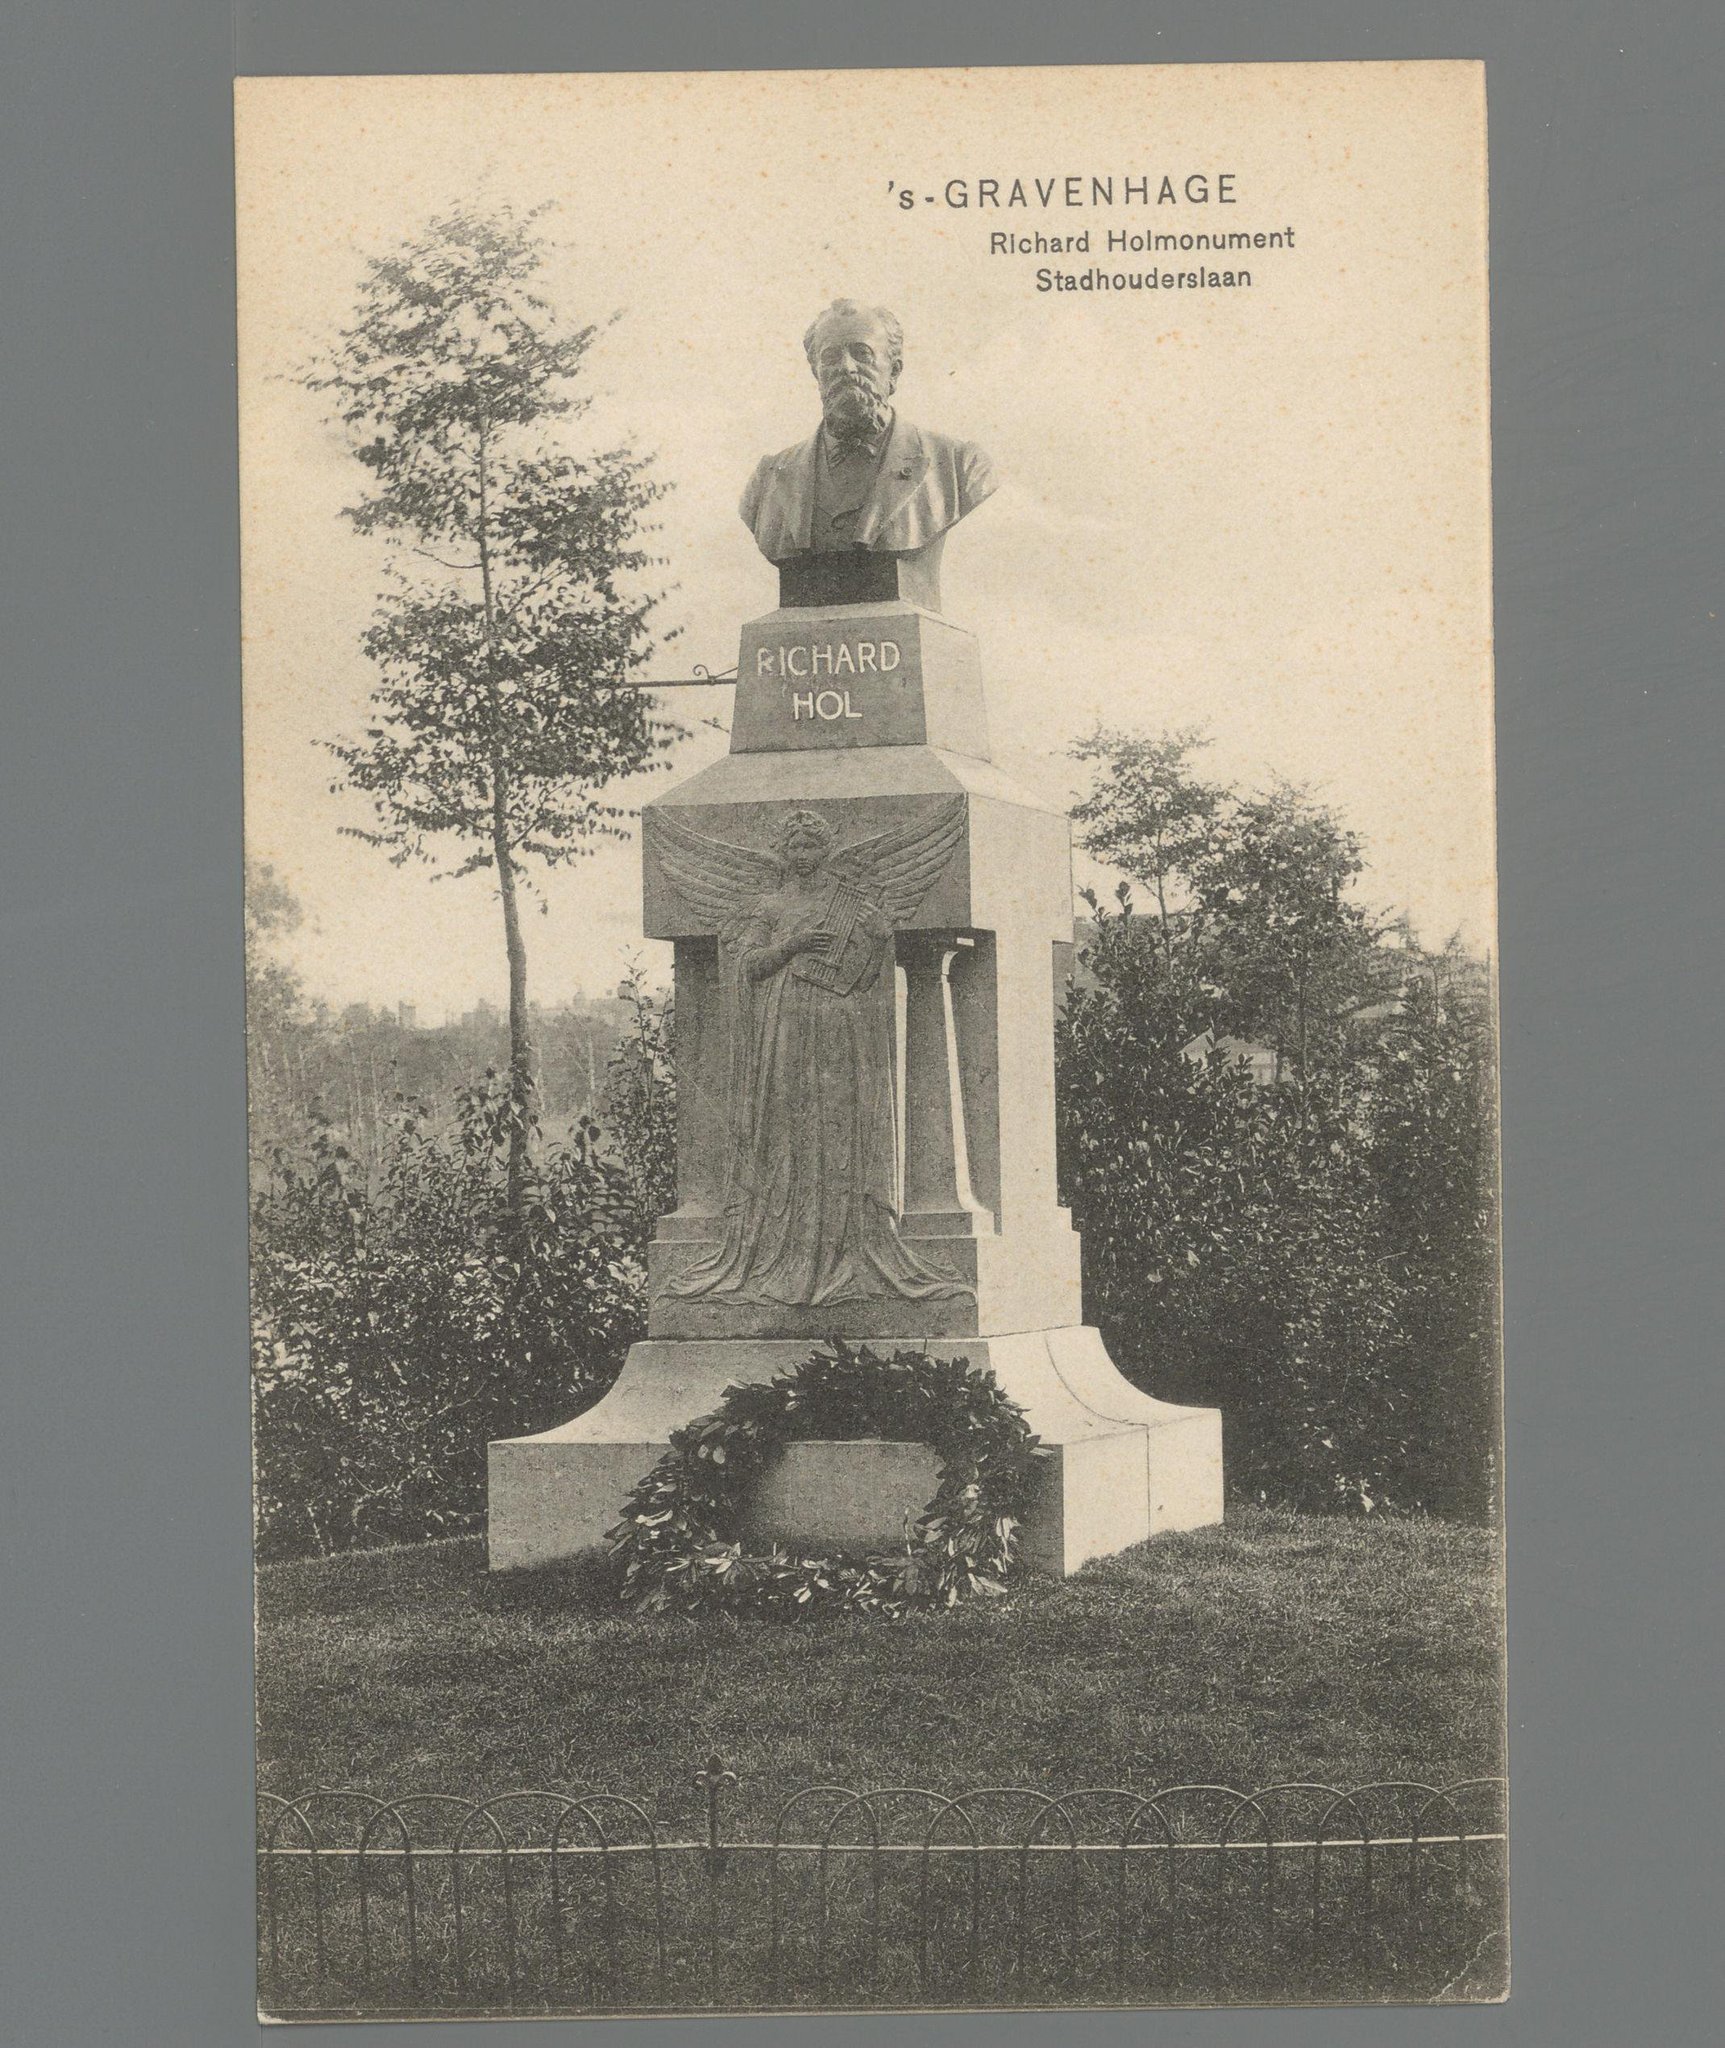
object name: ansichtkaart, prentbriefkaart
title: 's-Gravenhage. Richard Holmonument. Stadhouderslaan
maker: Anonymous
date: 1907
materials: cardboard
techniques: photograph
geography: leipzig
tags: garland, wreath, monument, statue, the composer and his muse, the hague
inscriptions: date